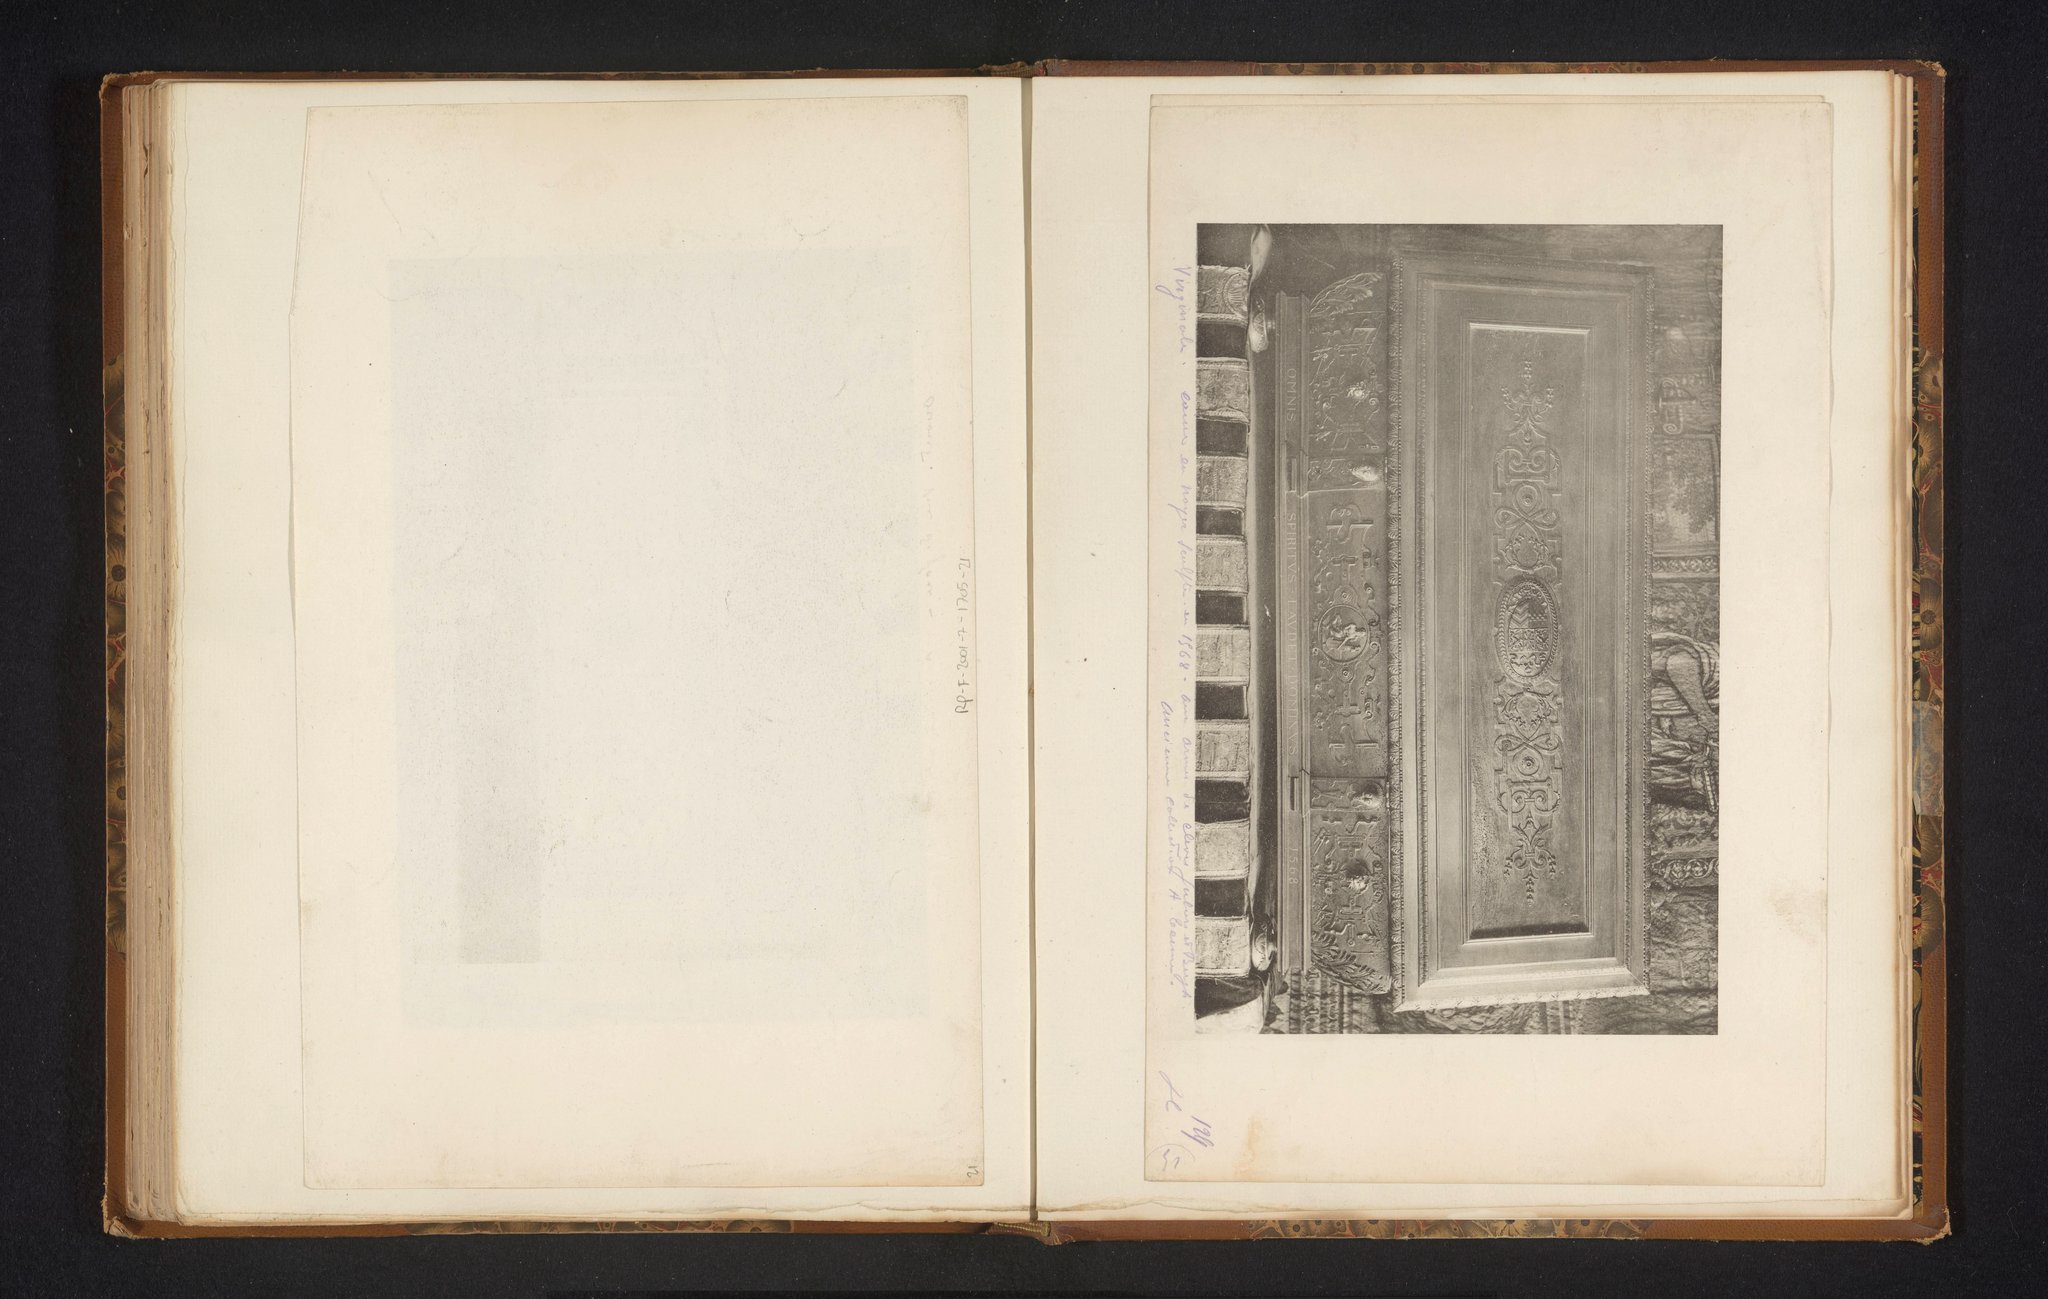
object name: page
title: Virginaal Hertog van Kleef uit de collectie van Antonin Terme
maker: Anonymous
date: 1880-1885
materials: paper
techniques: photograph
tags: art collection, art gallery, spinet, virginal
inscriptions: annotation: ‘Virginale - [...] en noyer sculpté en 1568 - aux arme du cleves Julius et Burgh/ [...] collection A. Terme/ 129 =’